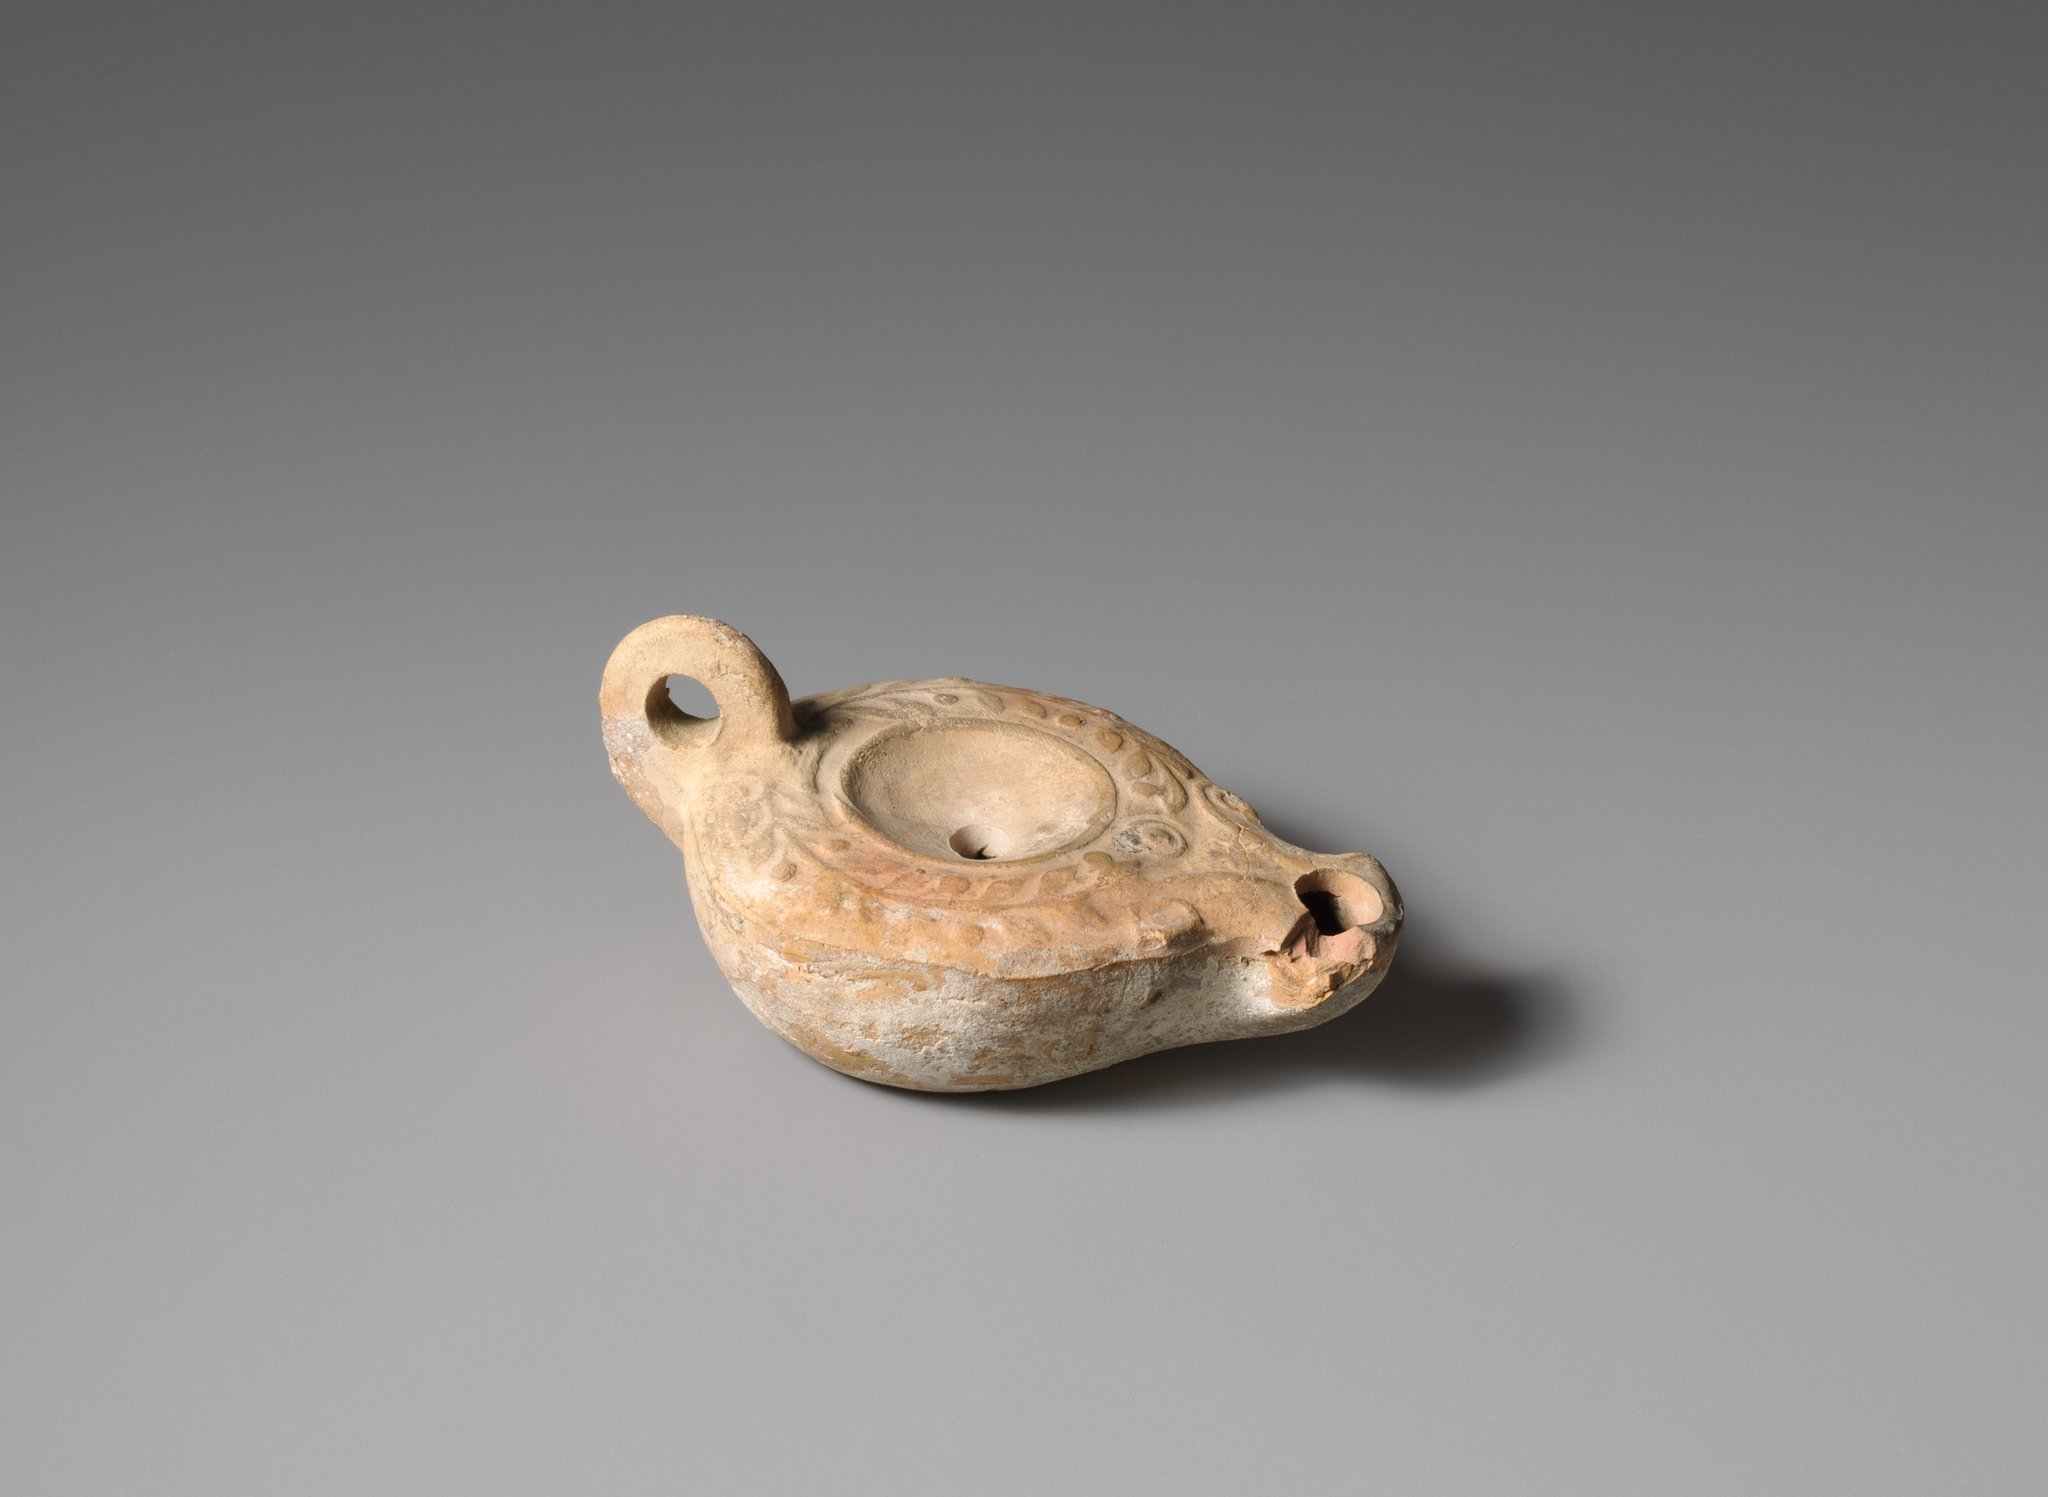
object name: lamp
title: Terracotta oil lamp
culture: greek or roman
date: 100 BCE-100 CE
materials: terracotta